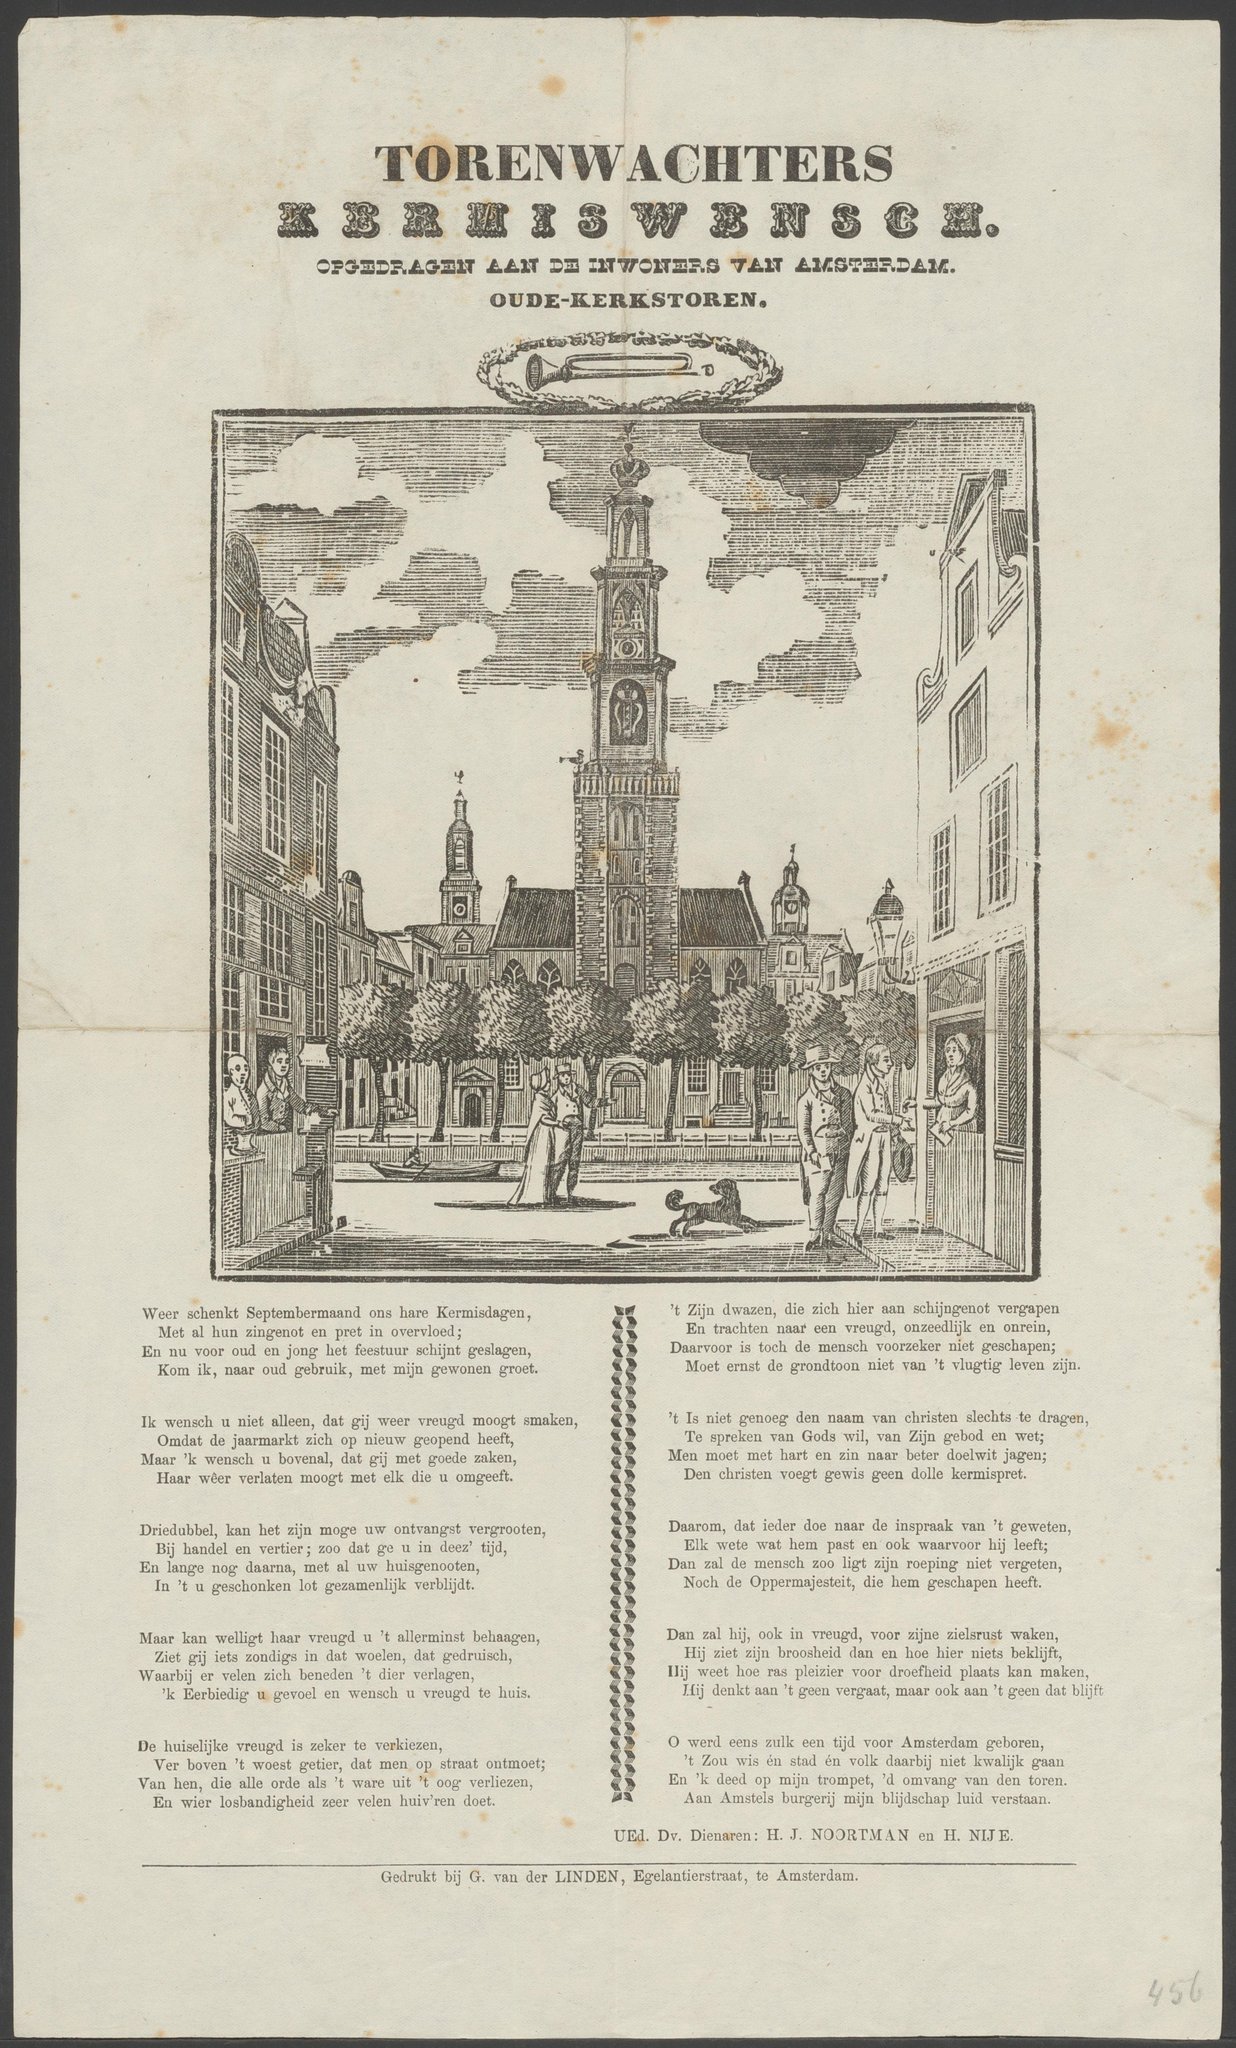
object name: print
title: Torenwachters Kermiswensch aan de inwoners van Amsterdam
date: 1860-1875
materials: paper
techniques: letterpress printing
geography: amsterdam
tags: night patrol, tower (of house or building)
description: Kermiswens van de torenwachters van de stad Amsterdam. Bovenaan een trompet met daaronder een een toren in de stad Amterdam met een torenwachter. Onderaan een vers in twee kolommen. Aangeboden door de torenwachters: H.J. Noortman en H. Nije. Onderwerpsrubrieken binnen de Atlas Zeden en Gewoonten: Zeden en gewoonten in engeren zin, Volksleven, Volksbladen, Nieuwjaars- en Kerstwenschen, Amsterdam.